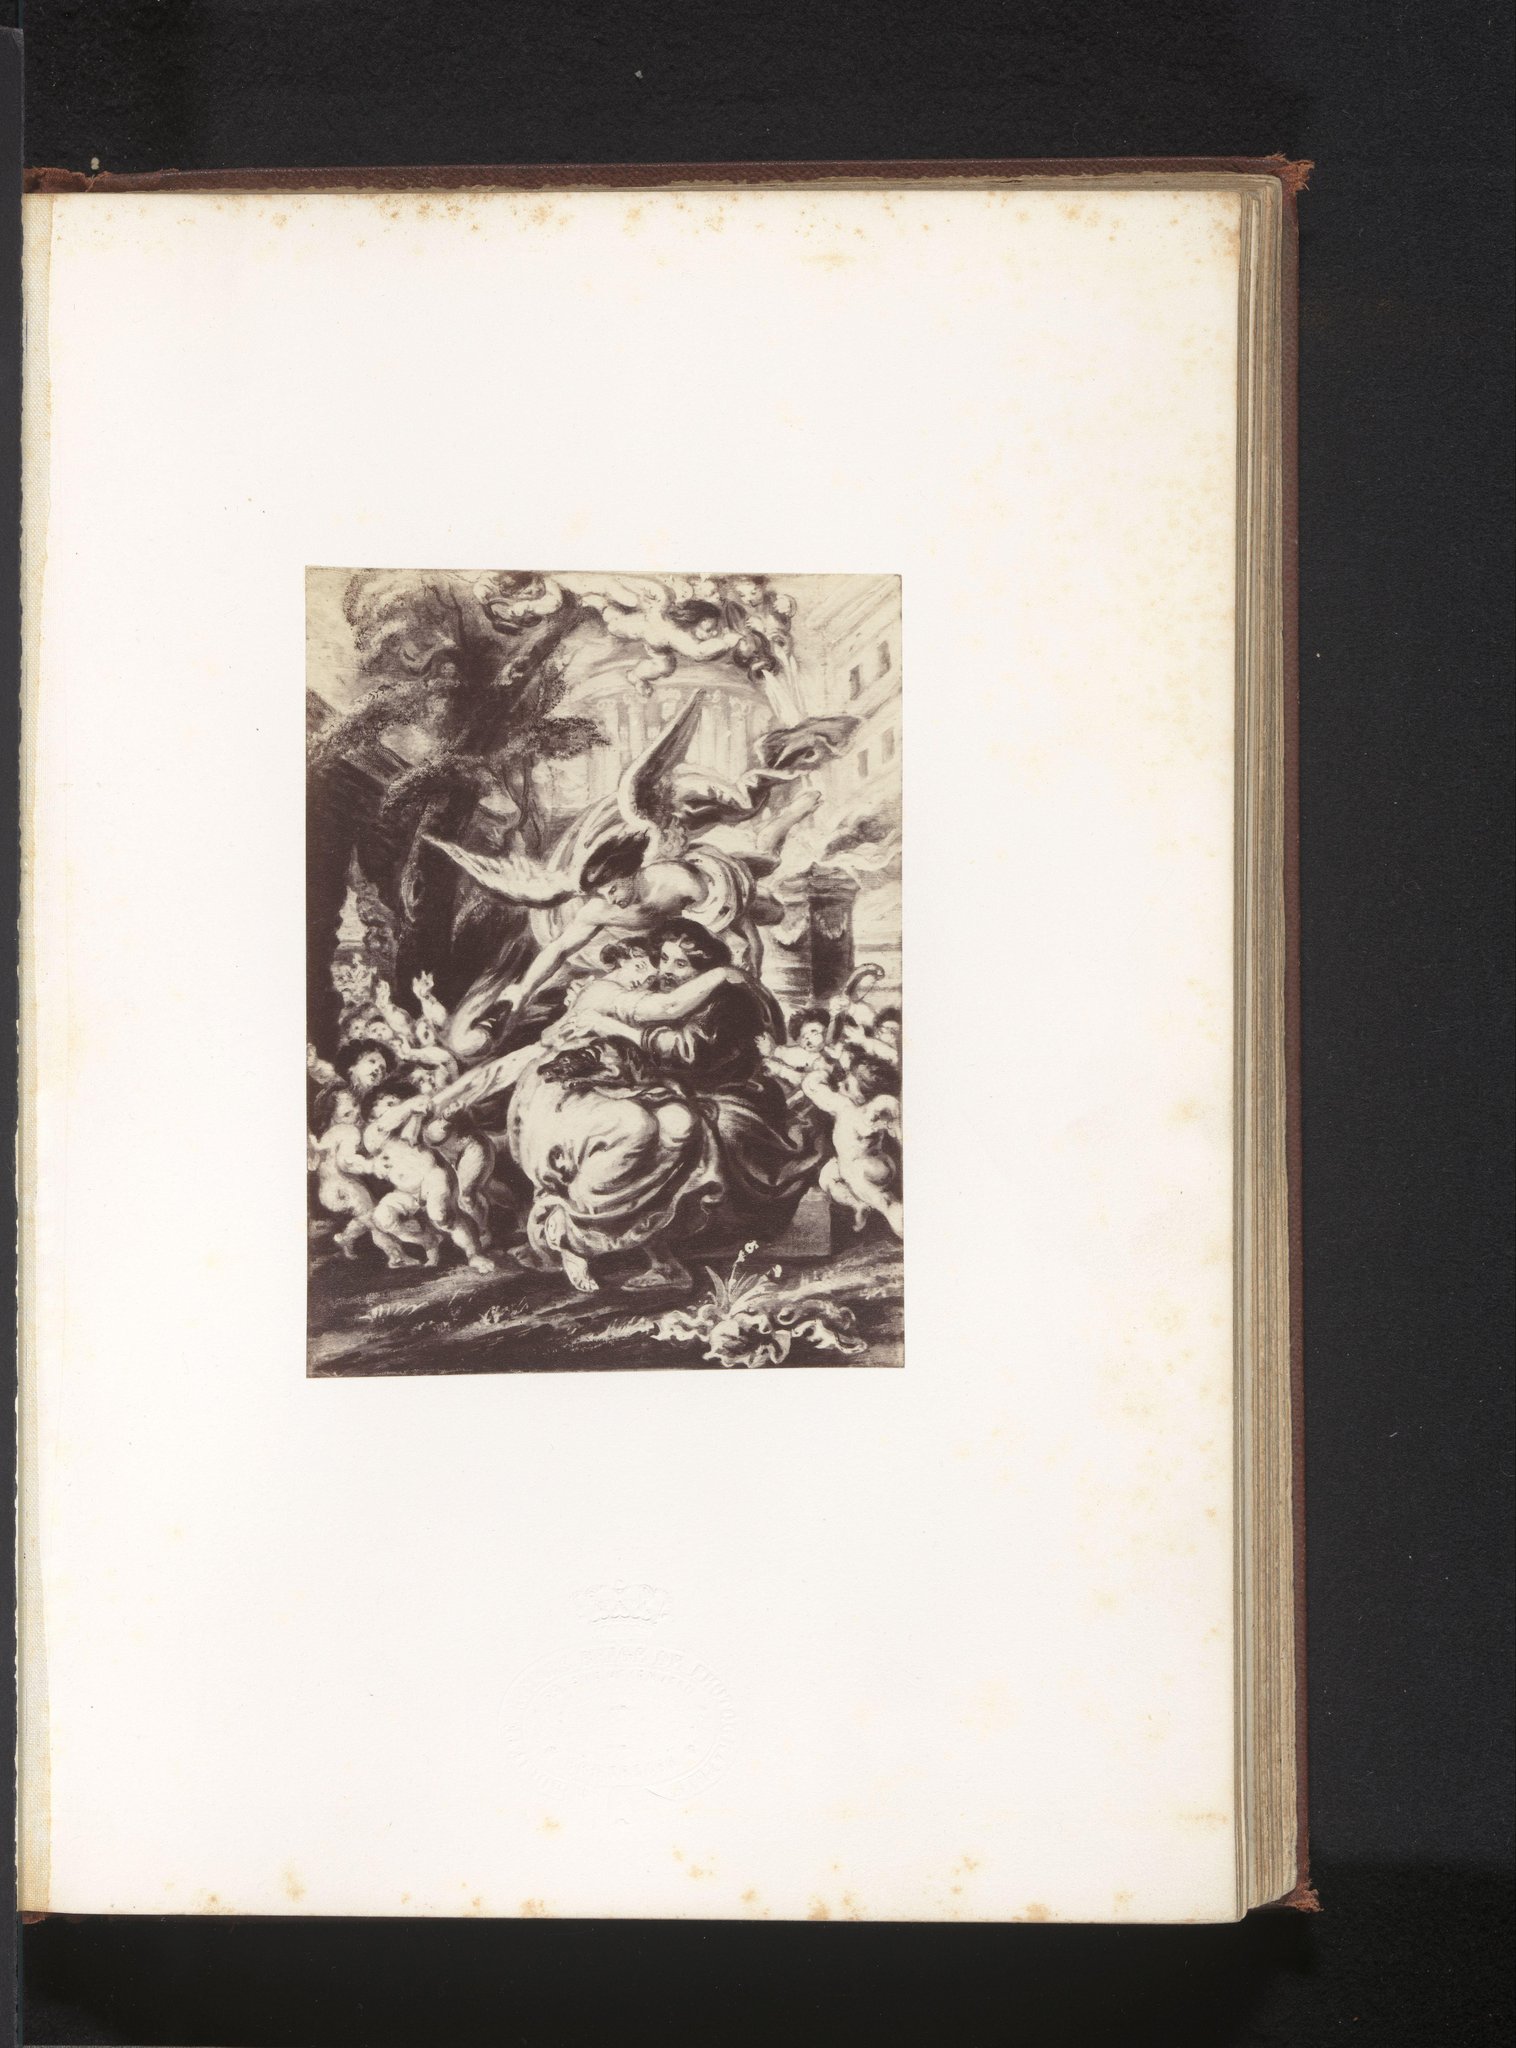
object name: photograph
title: Fotoreproductie van In familie II: De liefdestijden door Antoine Wiertz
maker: edmond fierlants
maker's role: fotograaf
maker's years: 1819-1869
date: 1863-1868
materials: photographic support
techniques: albumen print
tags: couple of lovers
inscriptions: check stamp: ‘SOCIÉTÉ ROYALE BELGE DE PHOTOGRAPHIE/ 69, RUE KEYENVELD/ BRUXELLES’